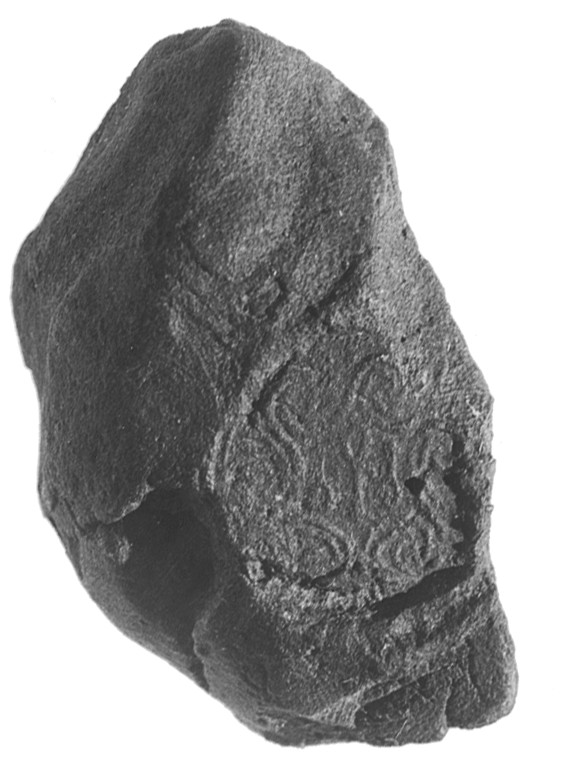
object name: sealing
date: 2030-1640 BCE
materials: clay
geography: egypt